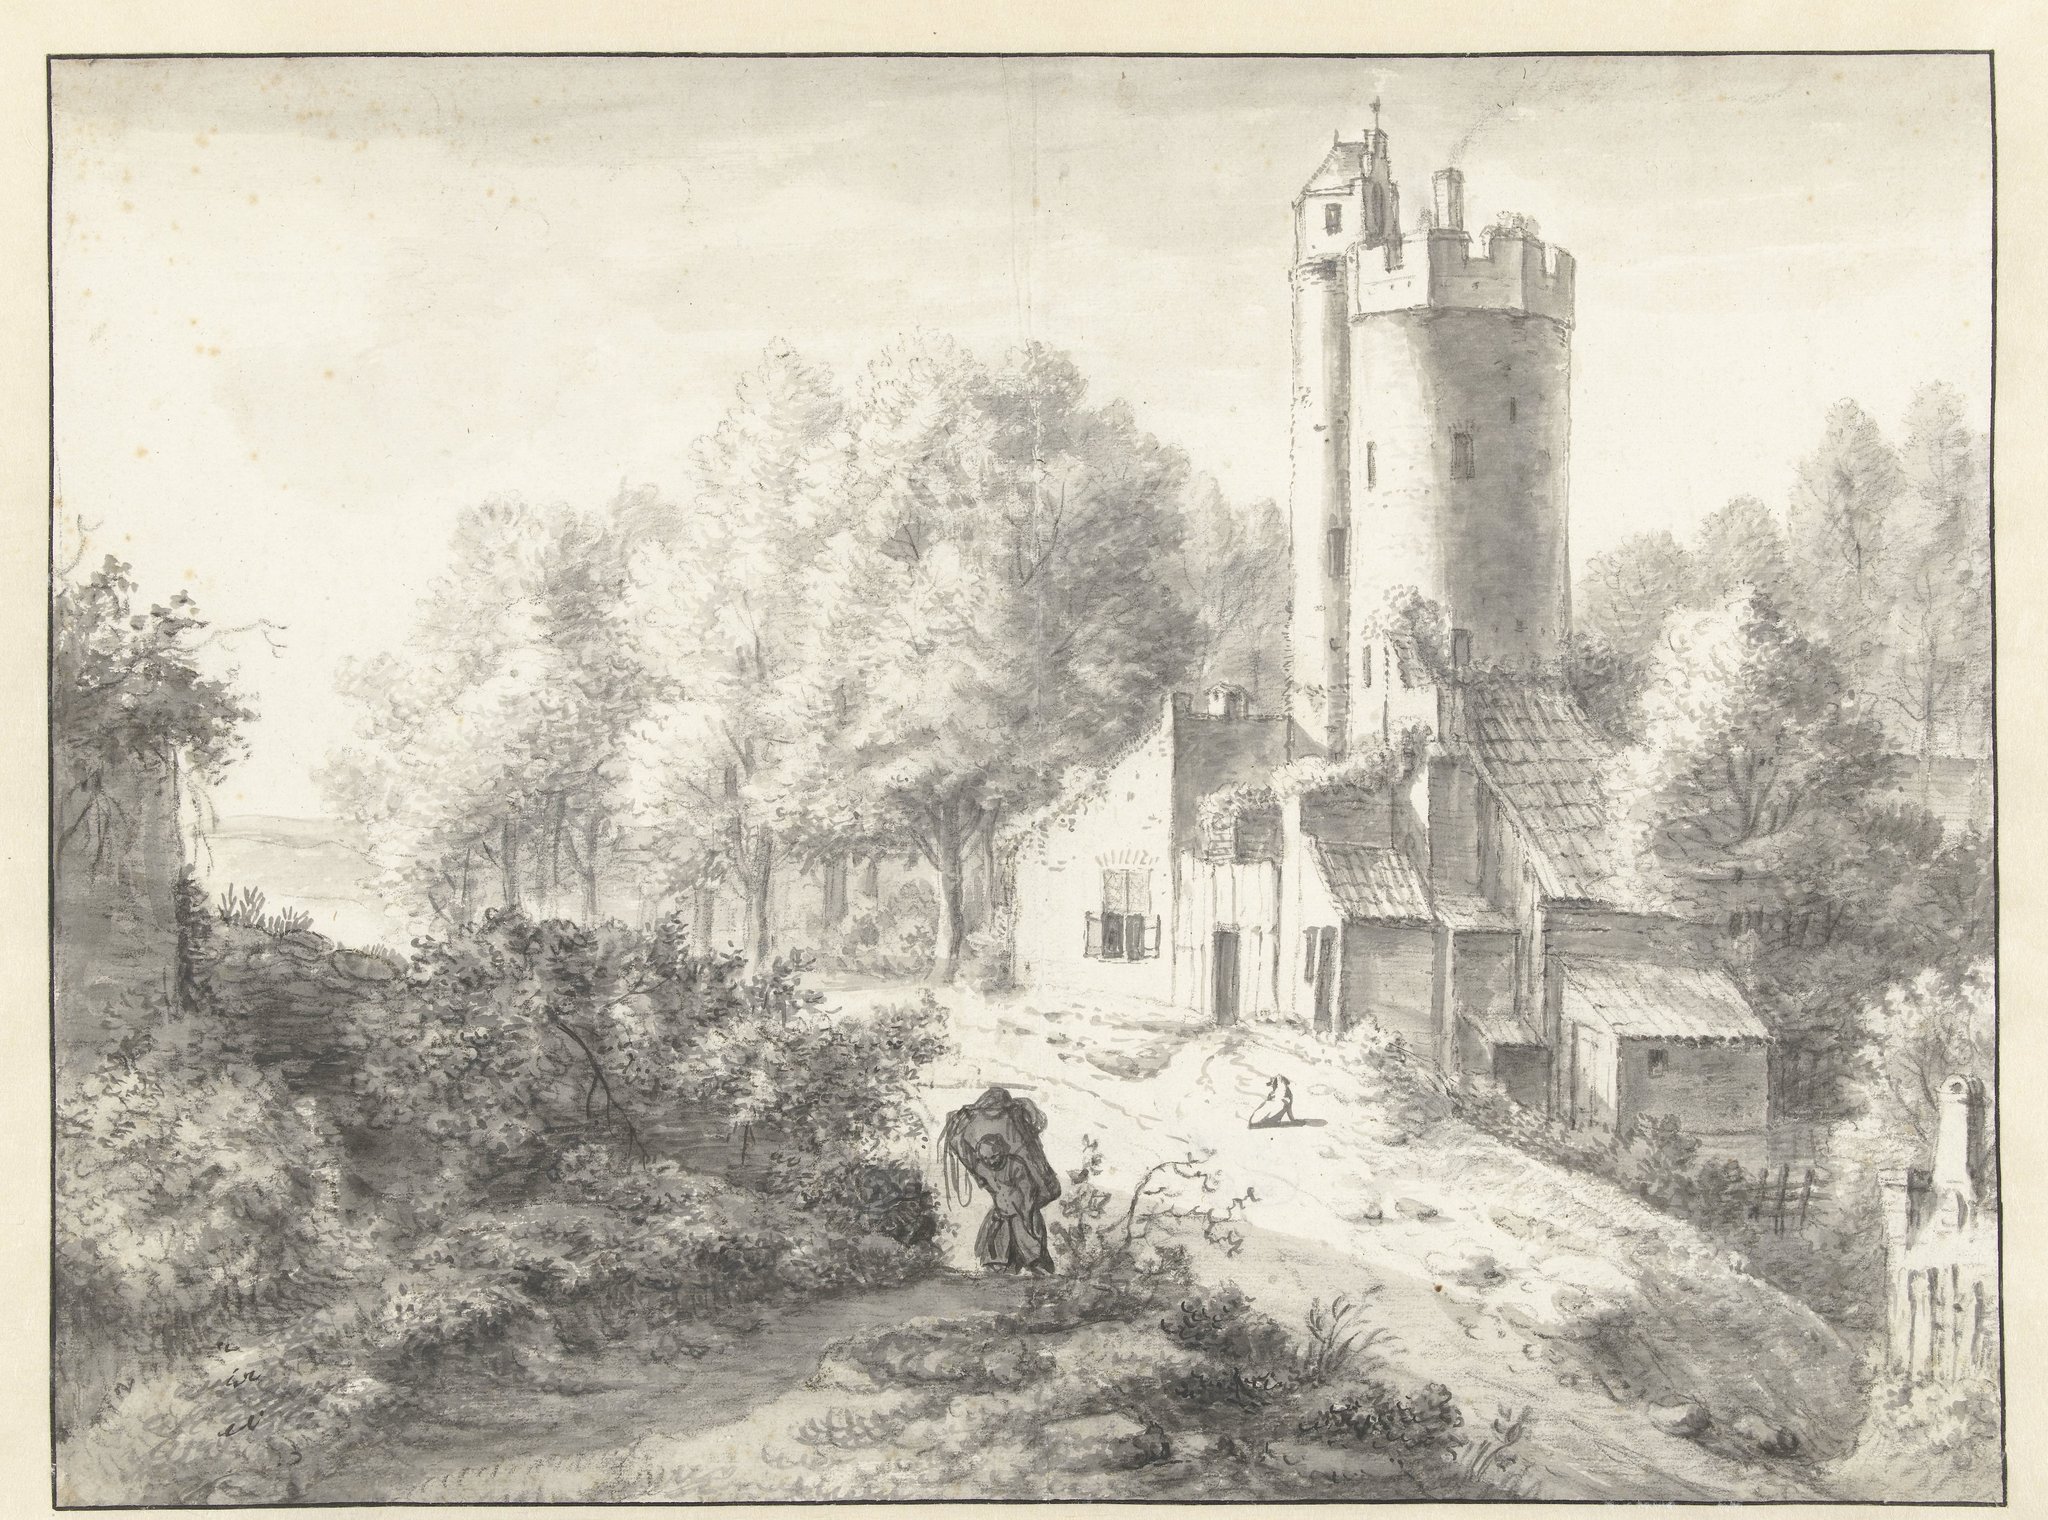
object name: drawing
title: Gezicht op de Bijlhouwerstoren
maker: anthonie waterloo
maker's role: draughtsman, painter, print maker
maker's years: 1609-1690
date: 1619-1690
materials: chalk, ink, paper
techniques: brush, pen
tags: landscape with tower or castle, utrecht